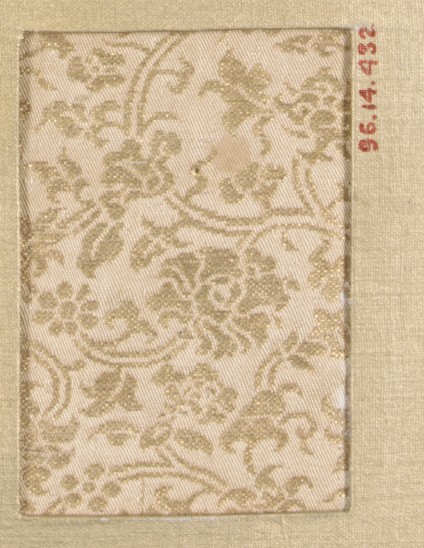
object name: piece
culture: japanese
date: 1701-1900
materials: silk